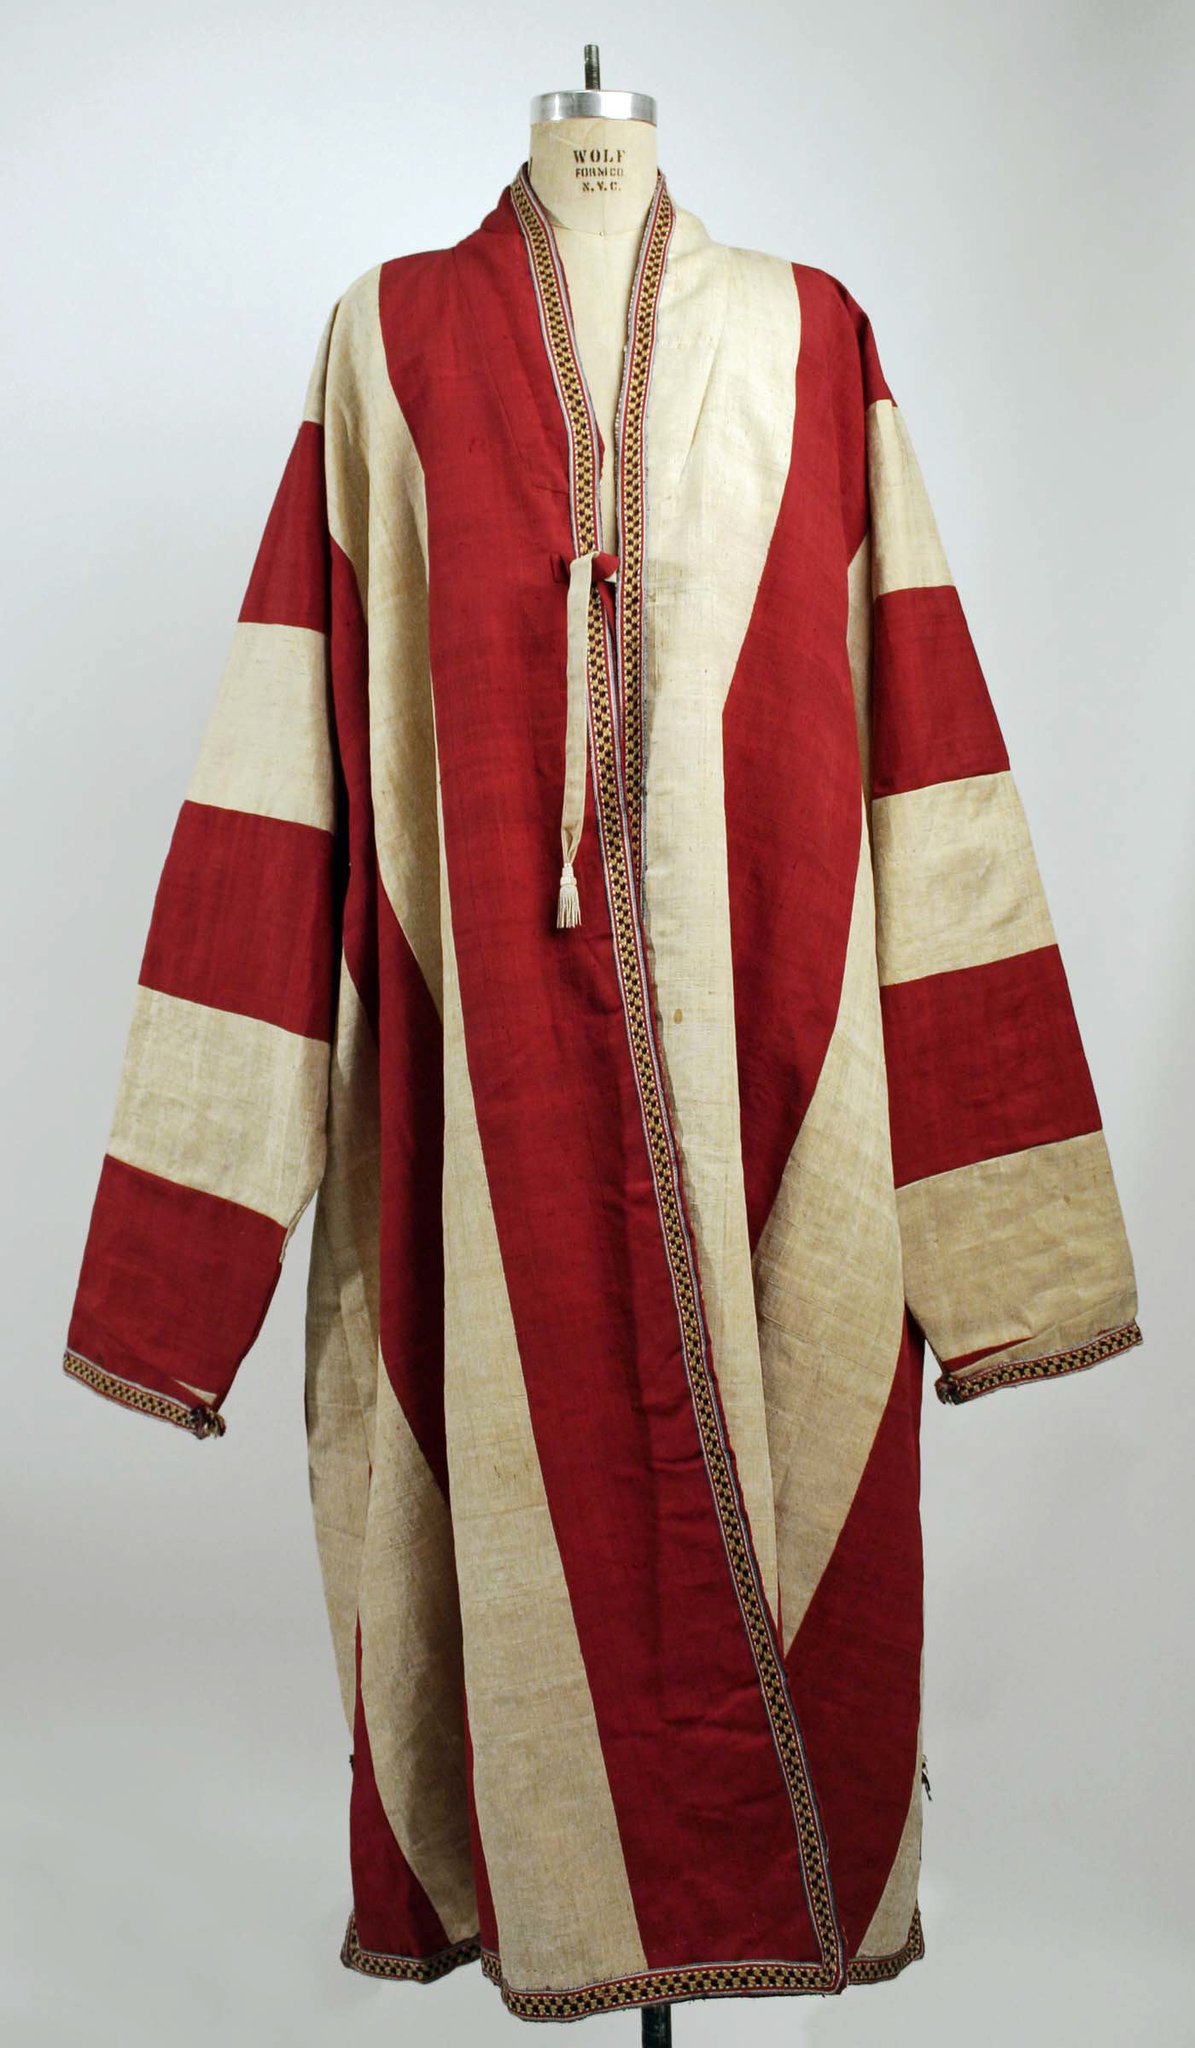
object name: robe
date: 1801-1900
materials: silk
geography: uzbekistan